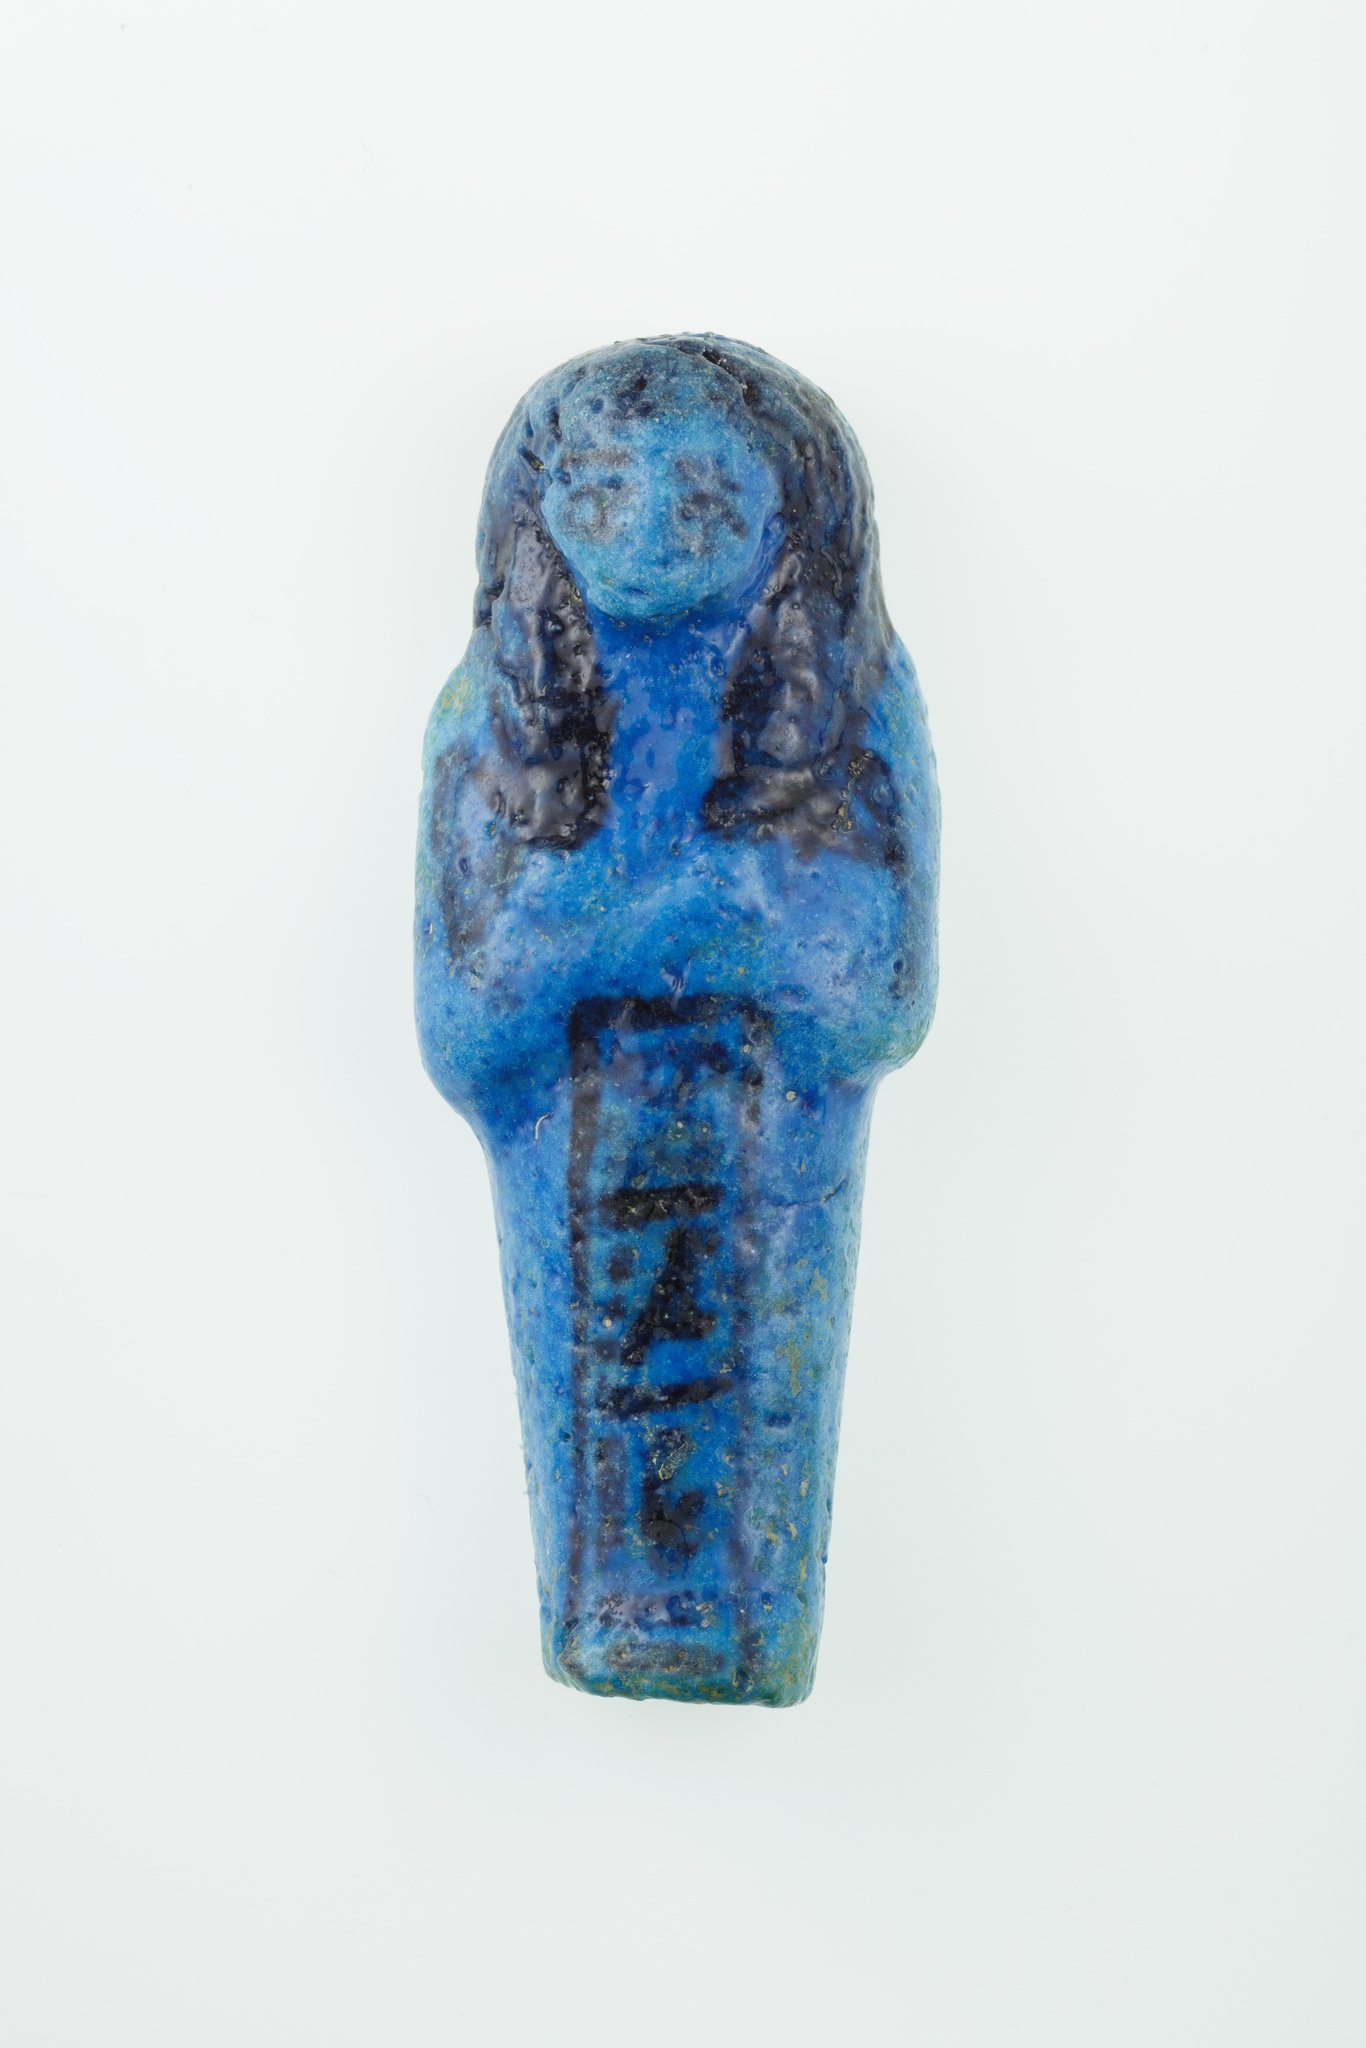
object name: shabti, worker, nauny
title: Worker Shabti of Nauny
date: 1050 BCE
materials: faience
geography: egypt